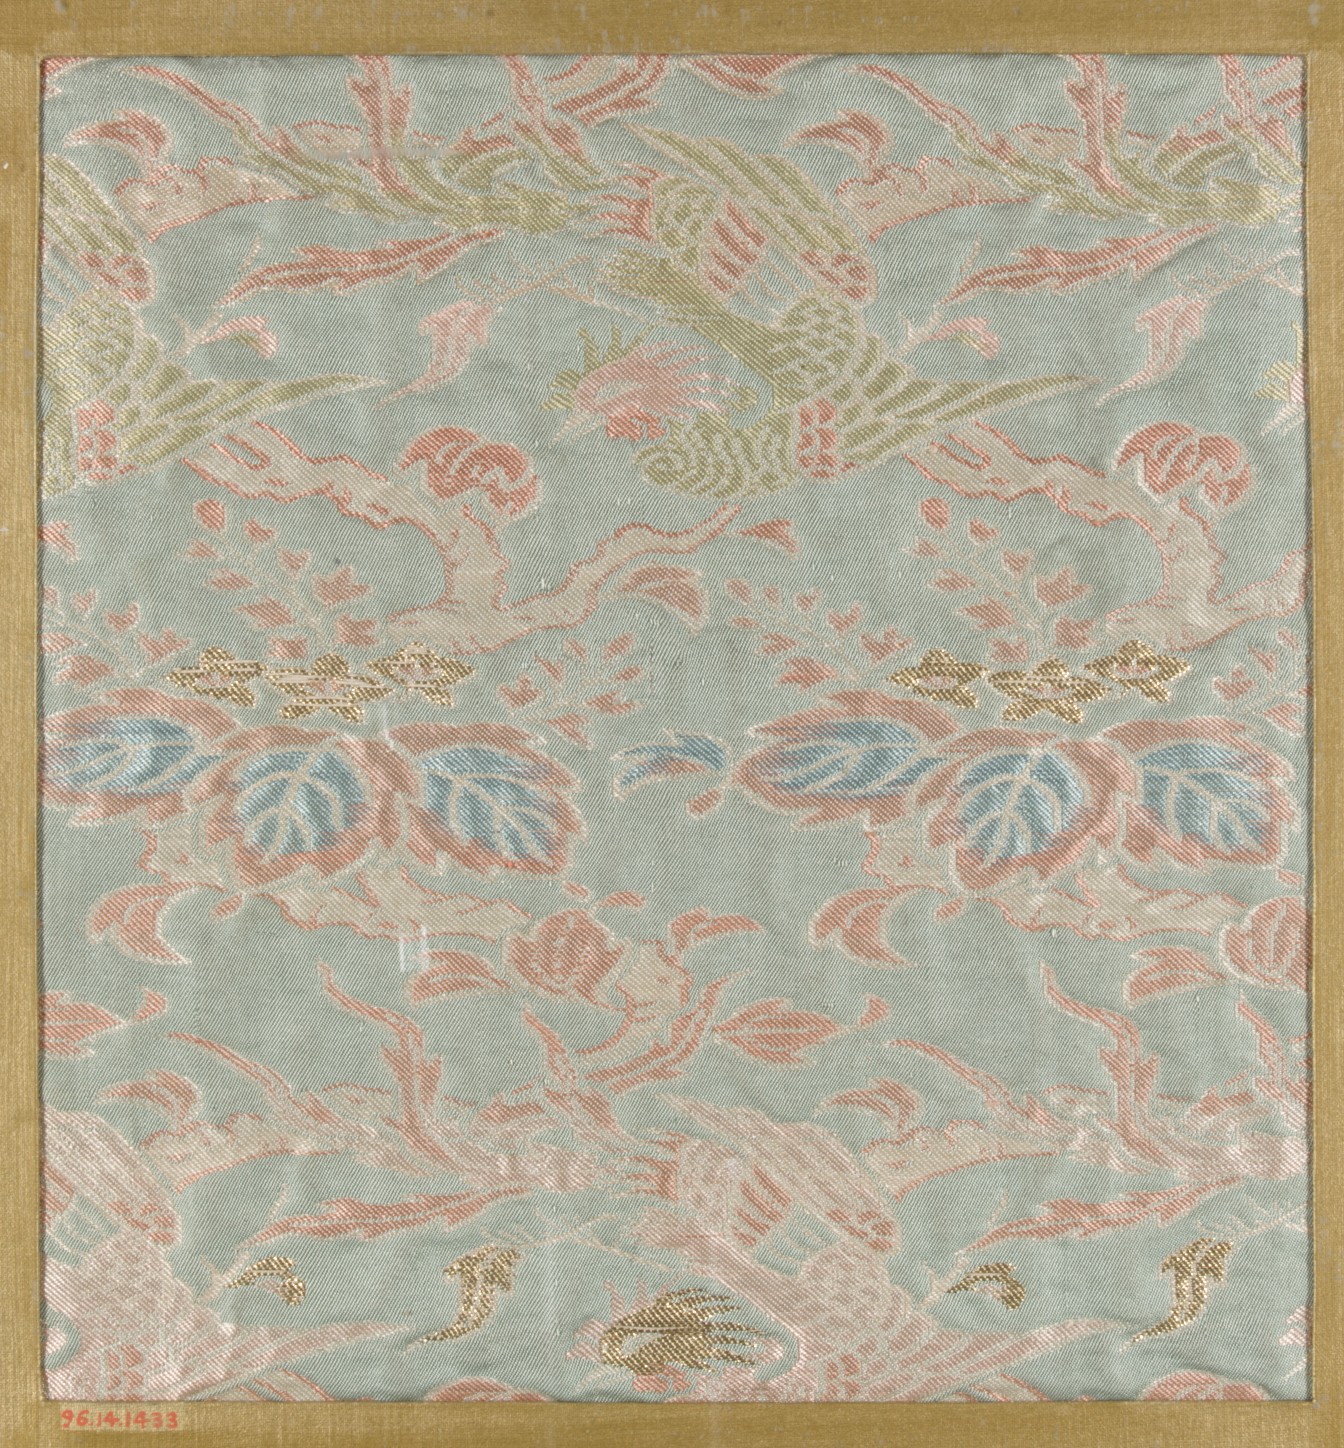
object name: piece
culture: japanese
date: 1701-1900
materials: silk